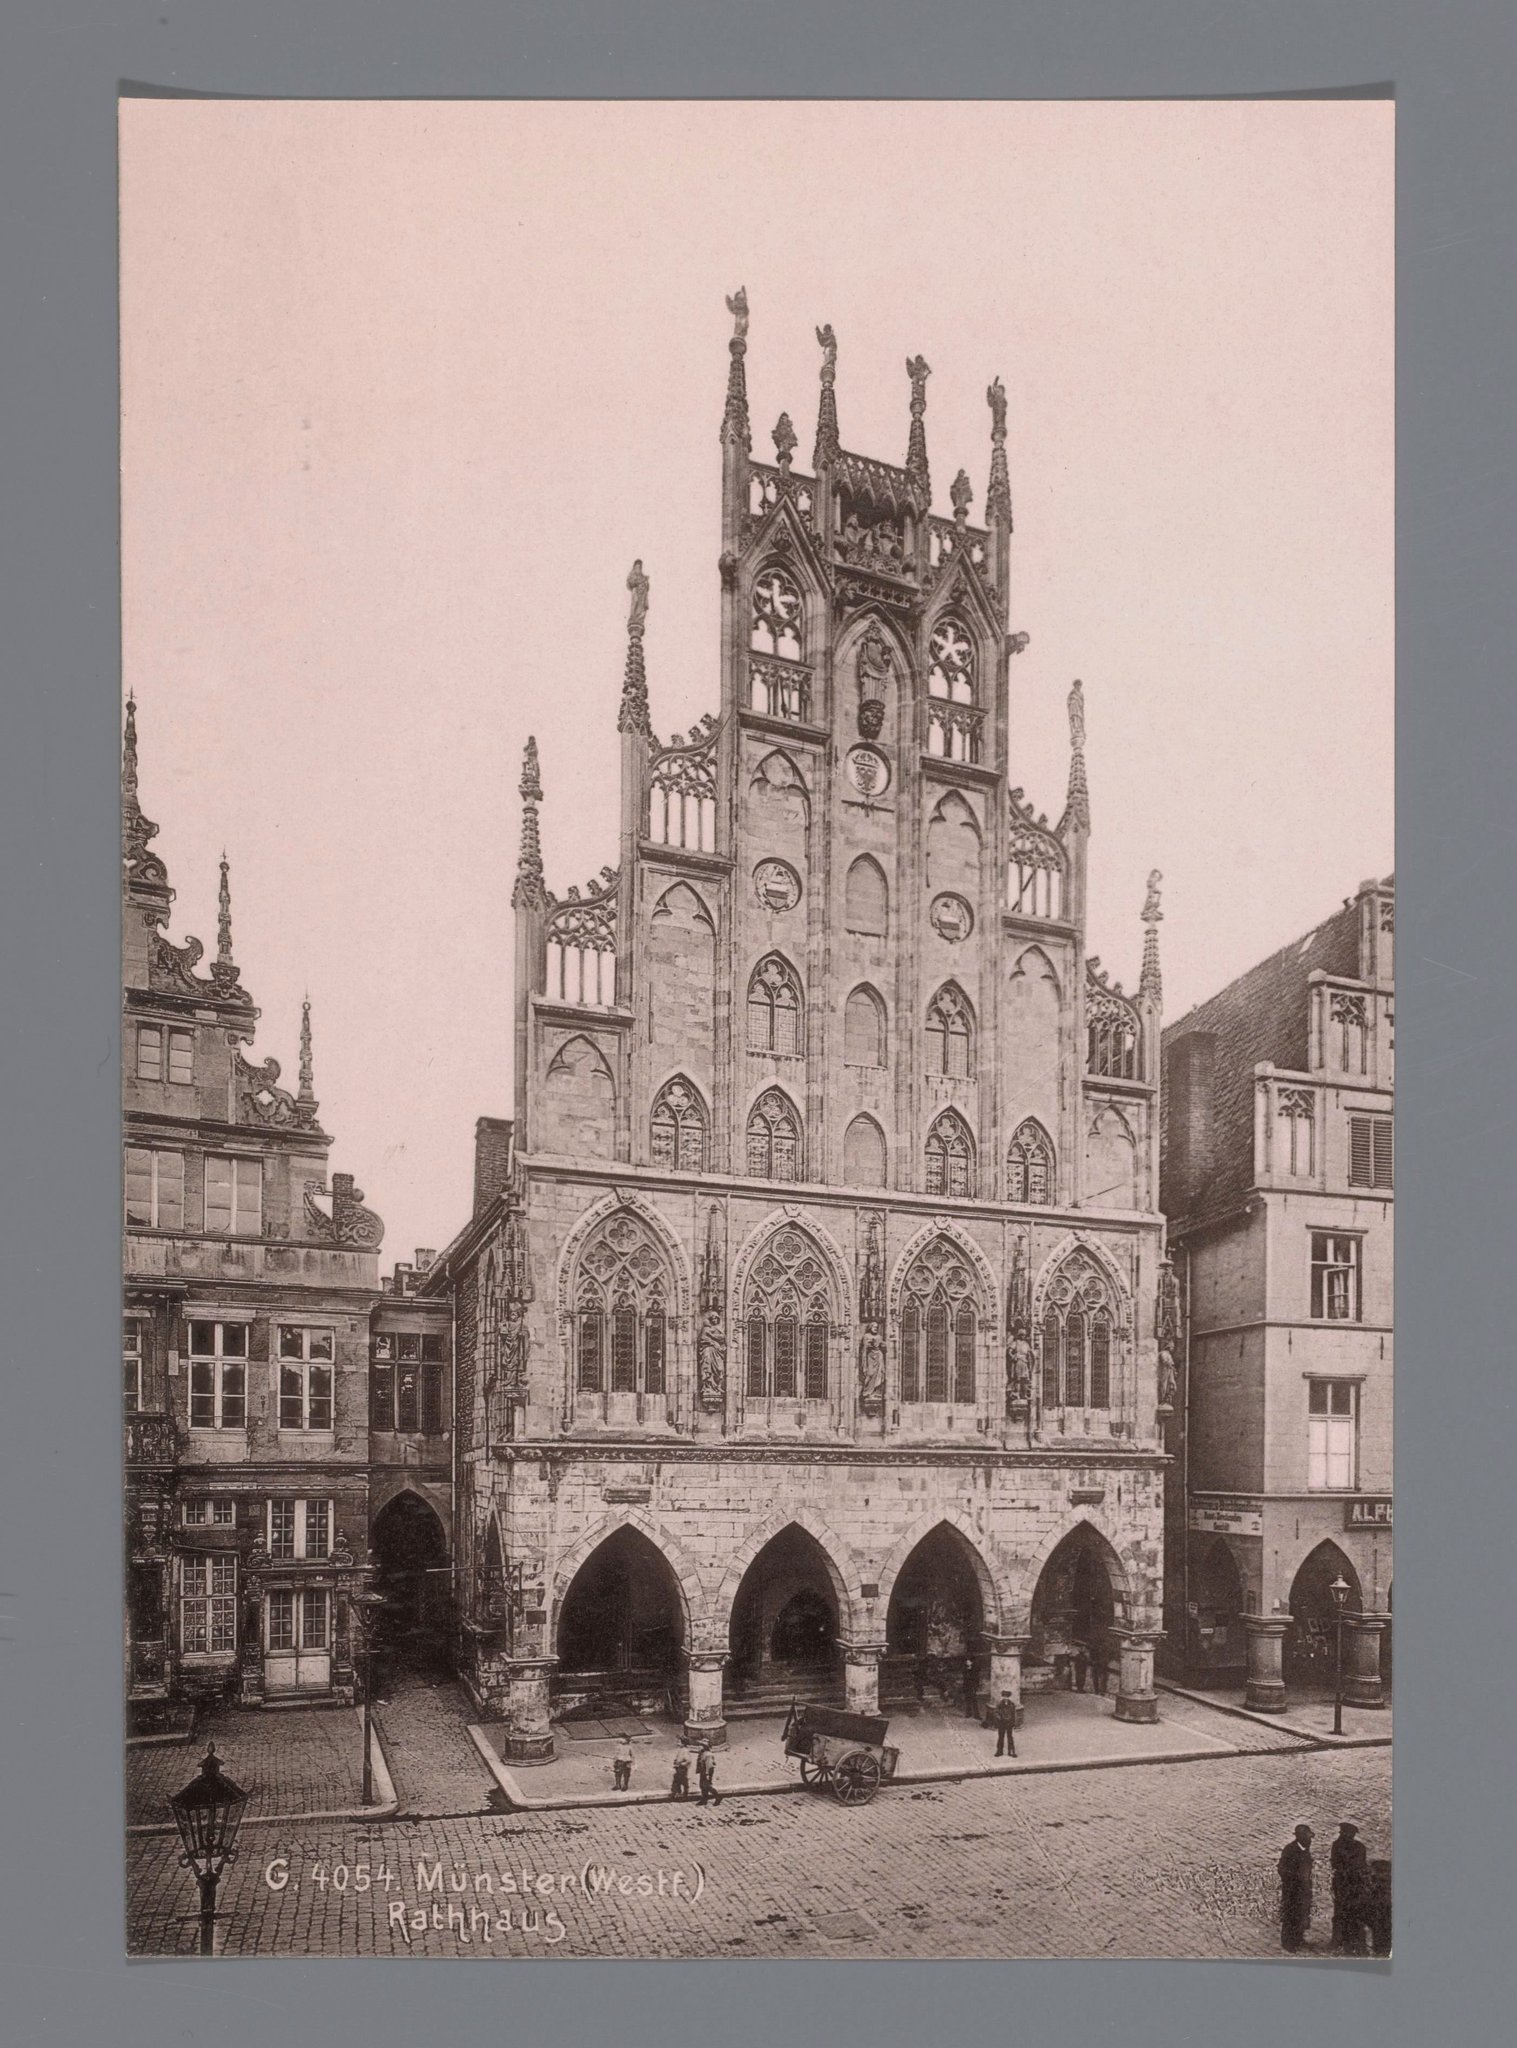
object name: photomechanical print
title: Stadhuis van Münster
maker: Anonymous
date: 1890-1910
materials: paper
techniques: photograph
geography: munster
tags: townhall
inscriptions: title: ‘G. 4054 Münster (Westf.)/ Rathhaus’